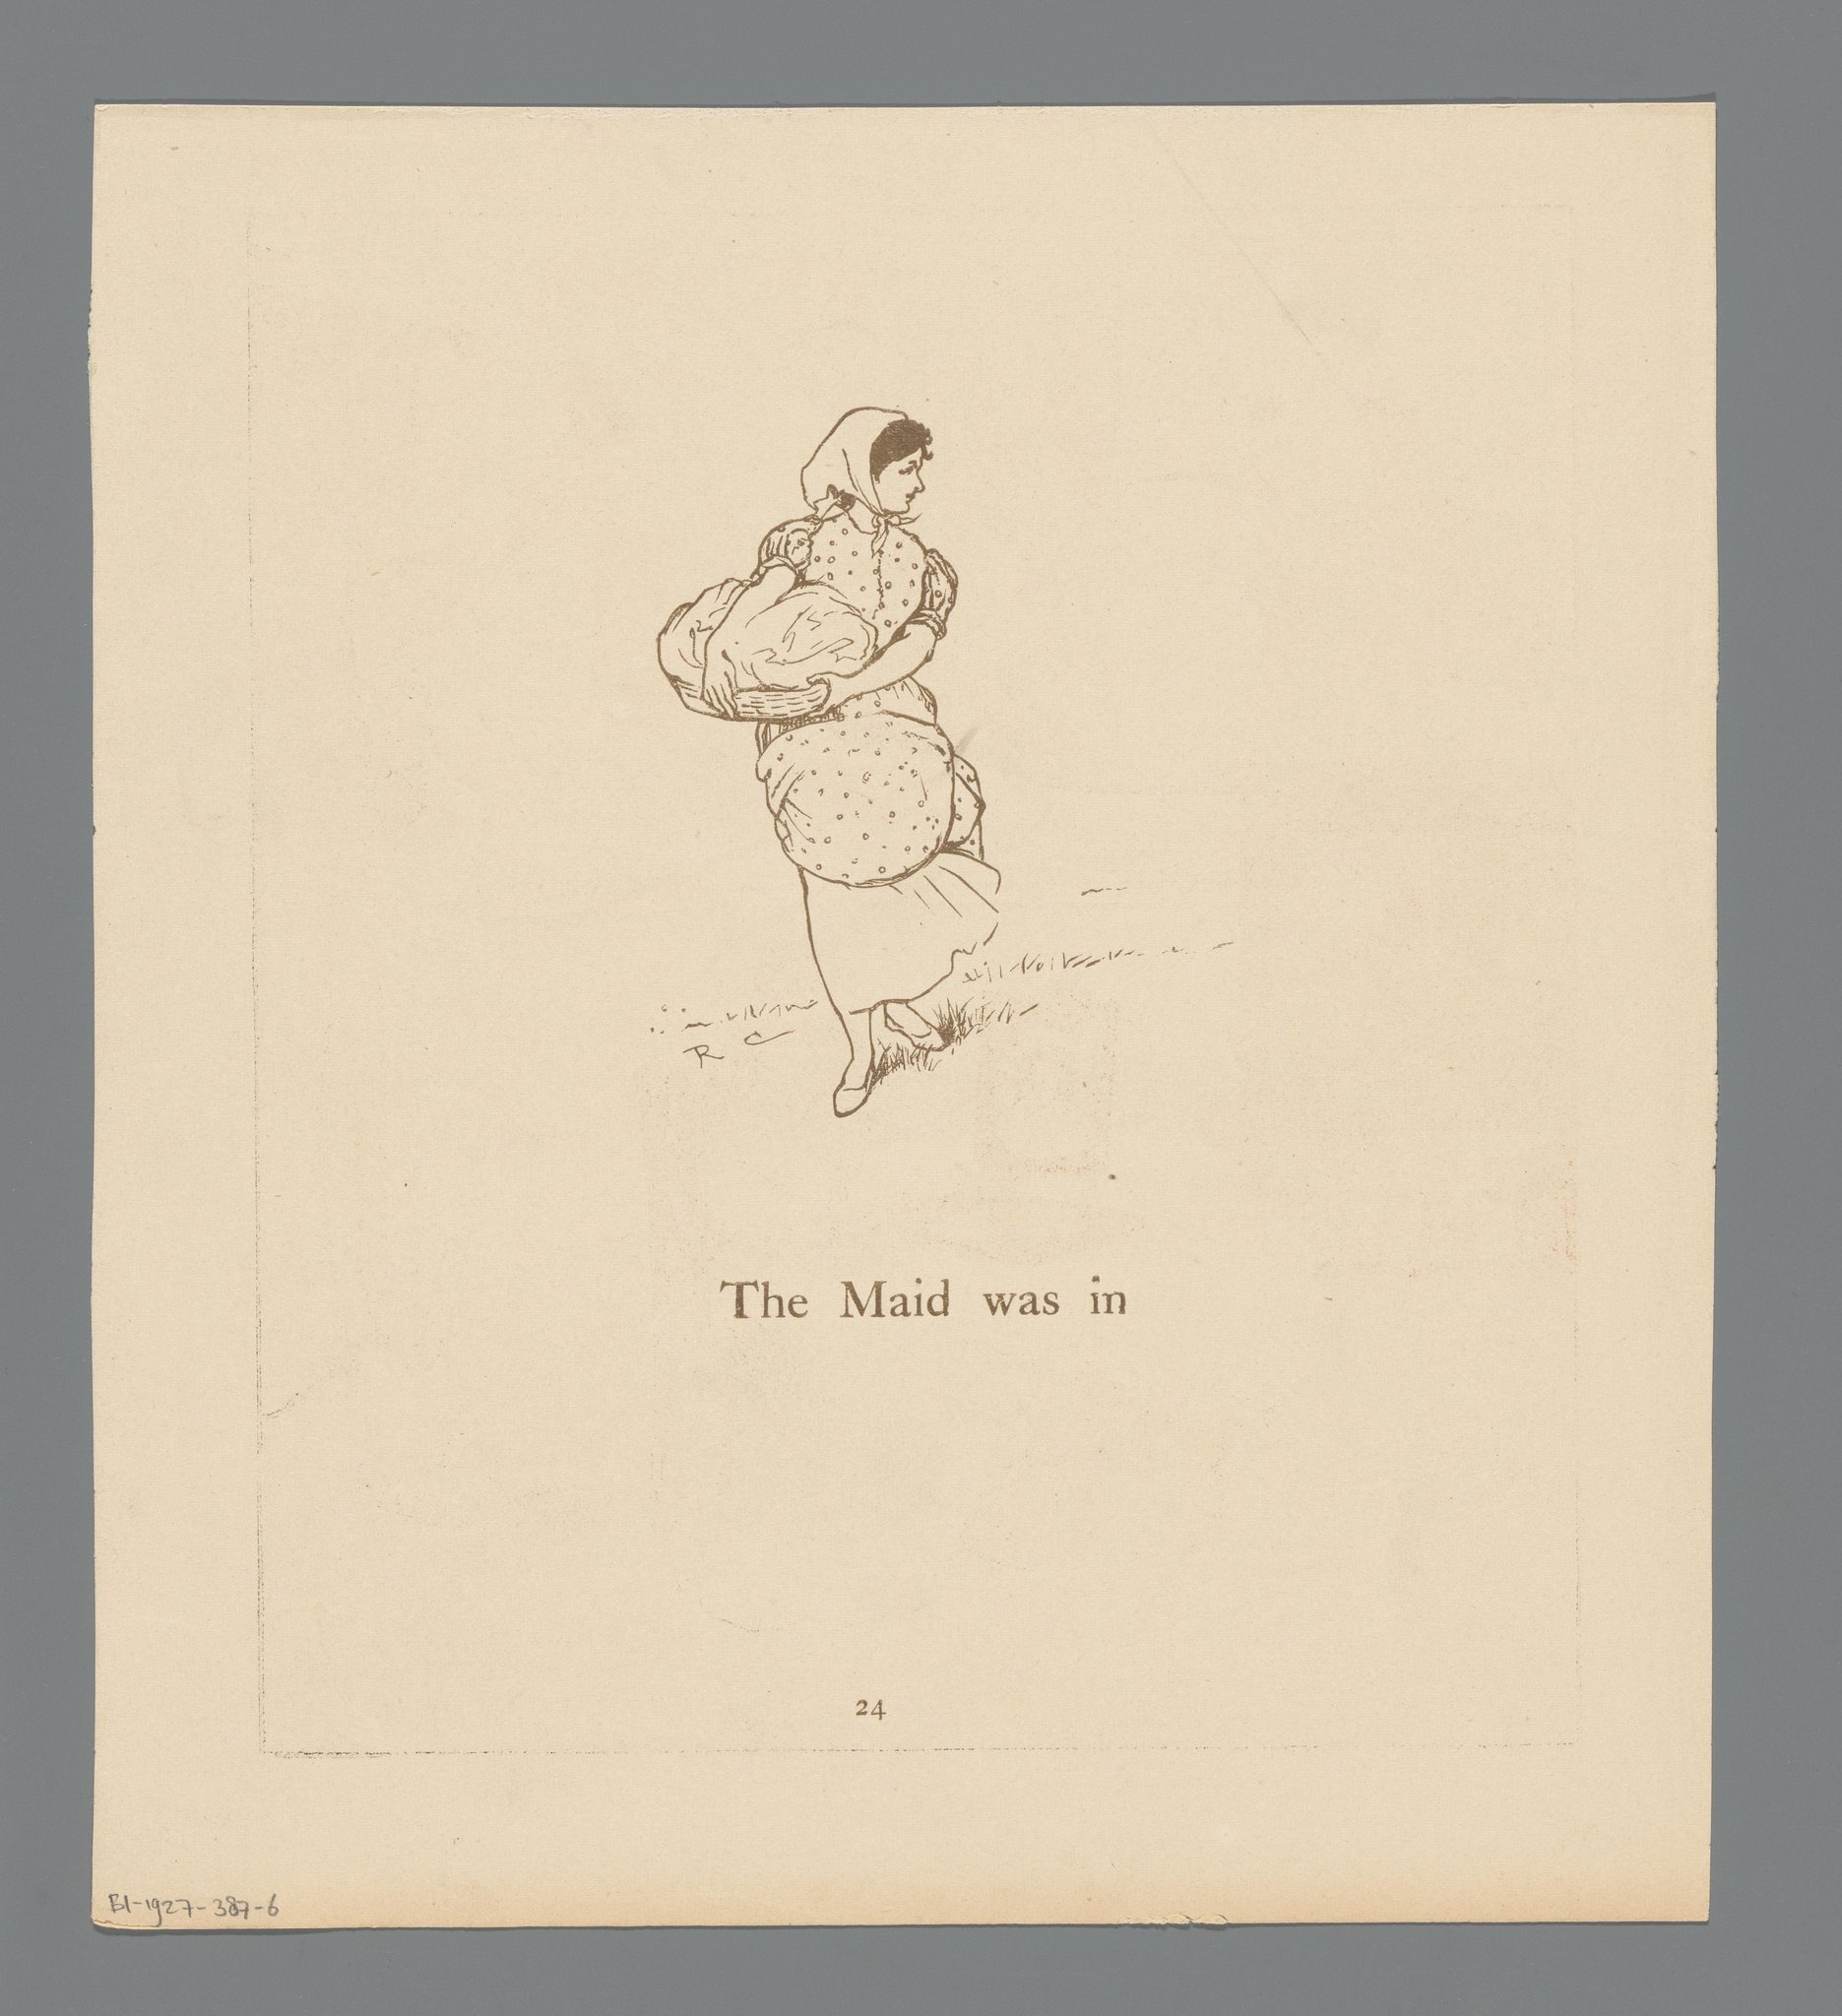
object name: book illustration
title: Vrouw met mand onder haar arm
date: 1880-1927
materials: paper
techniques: letterpress printing, engraving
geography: london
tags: carrying something, container made of plant material other than wood: basket, house personnel, servants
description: Prent uit: Sing a song of sixpence. Londen: George Routledge & Sons, 1880. Of uit een later gepubliceerde (gebundelde) uitgave.